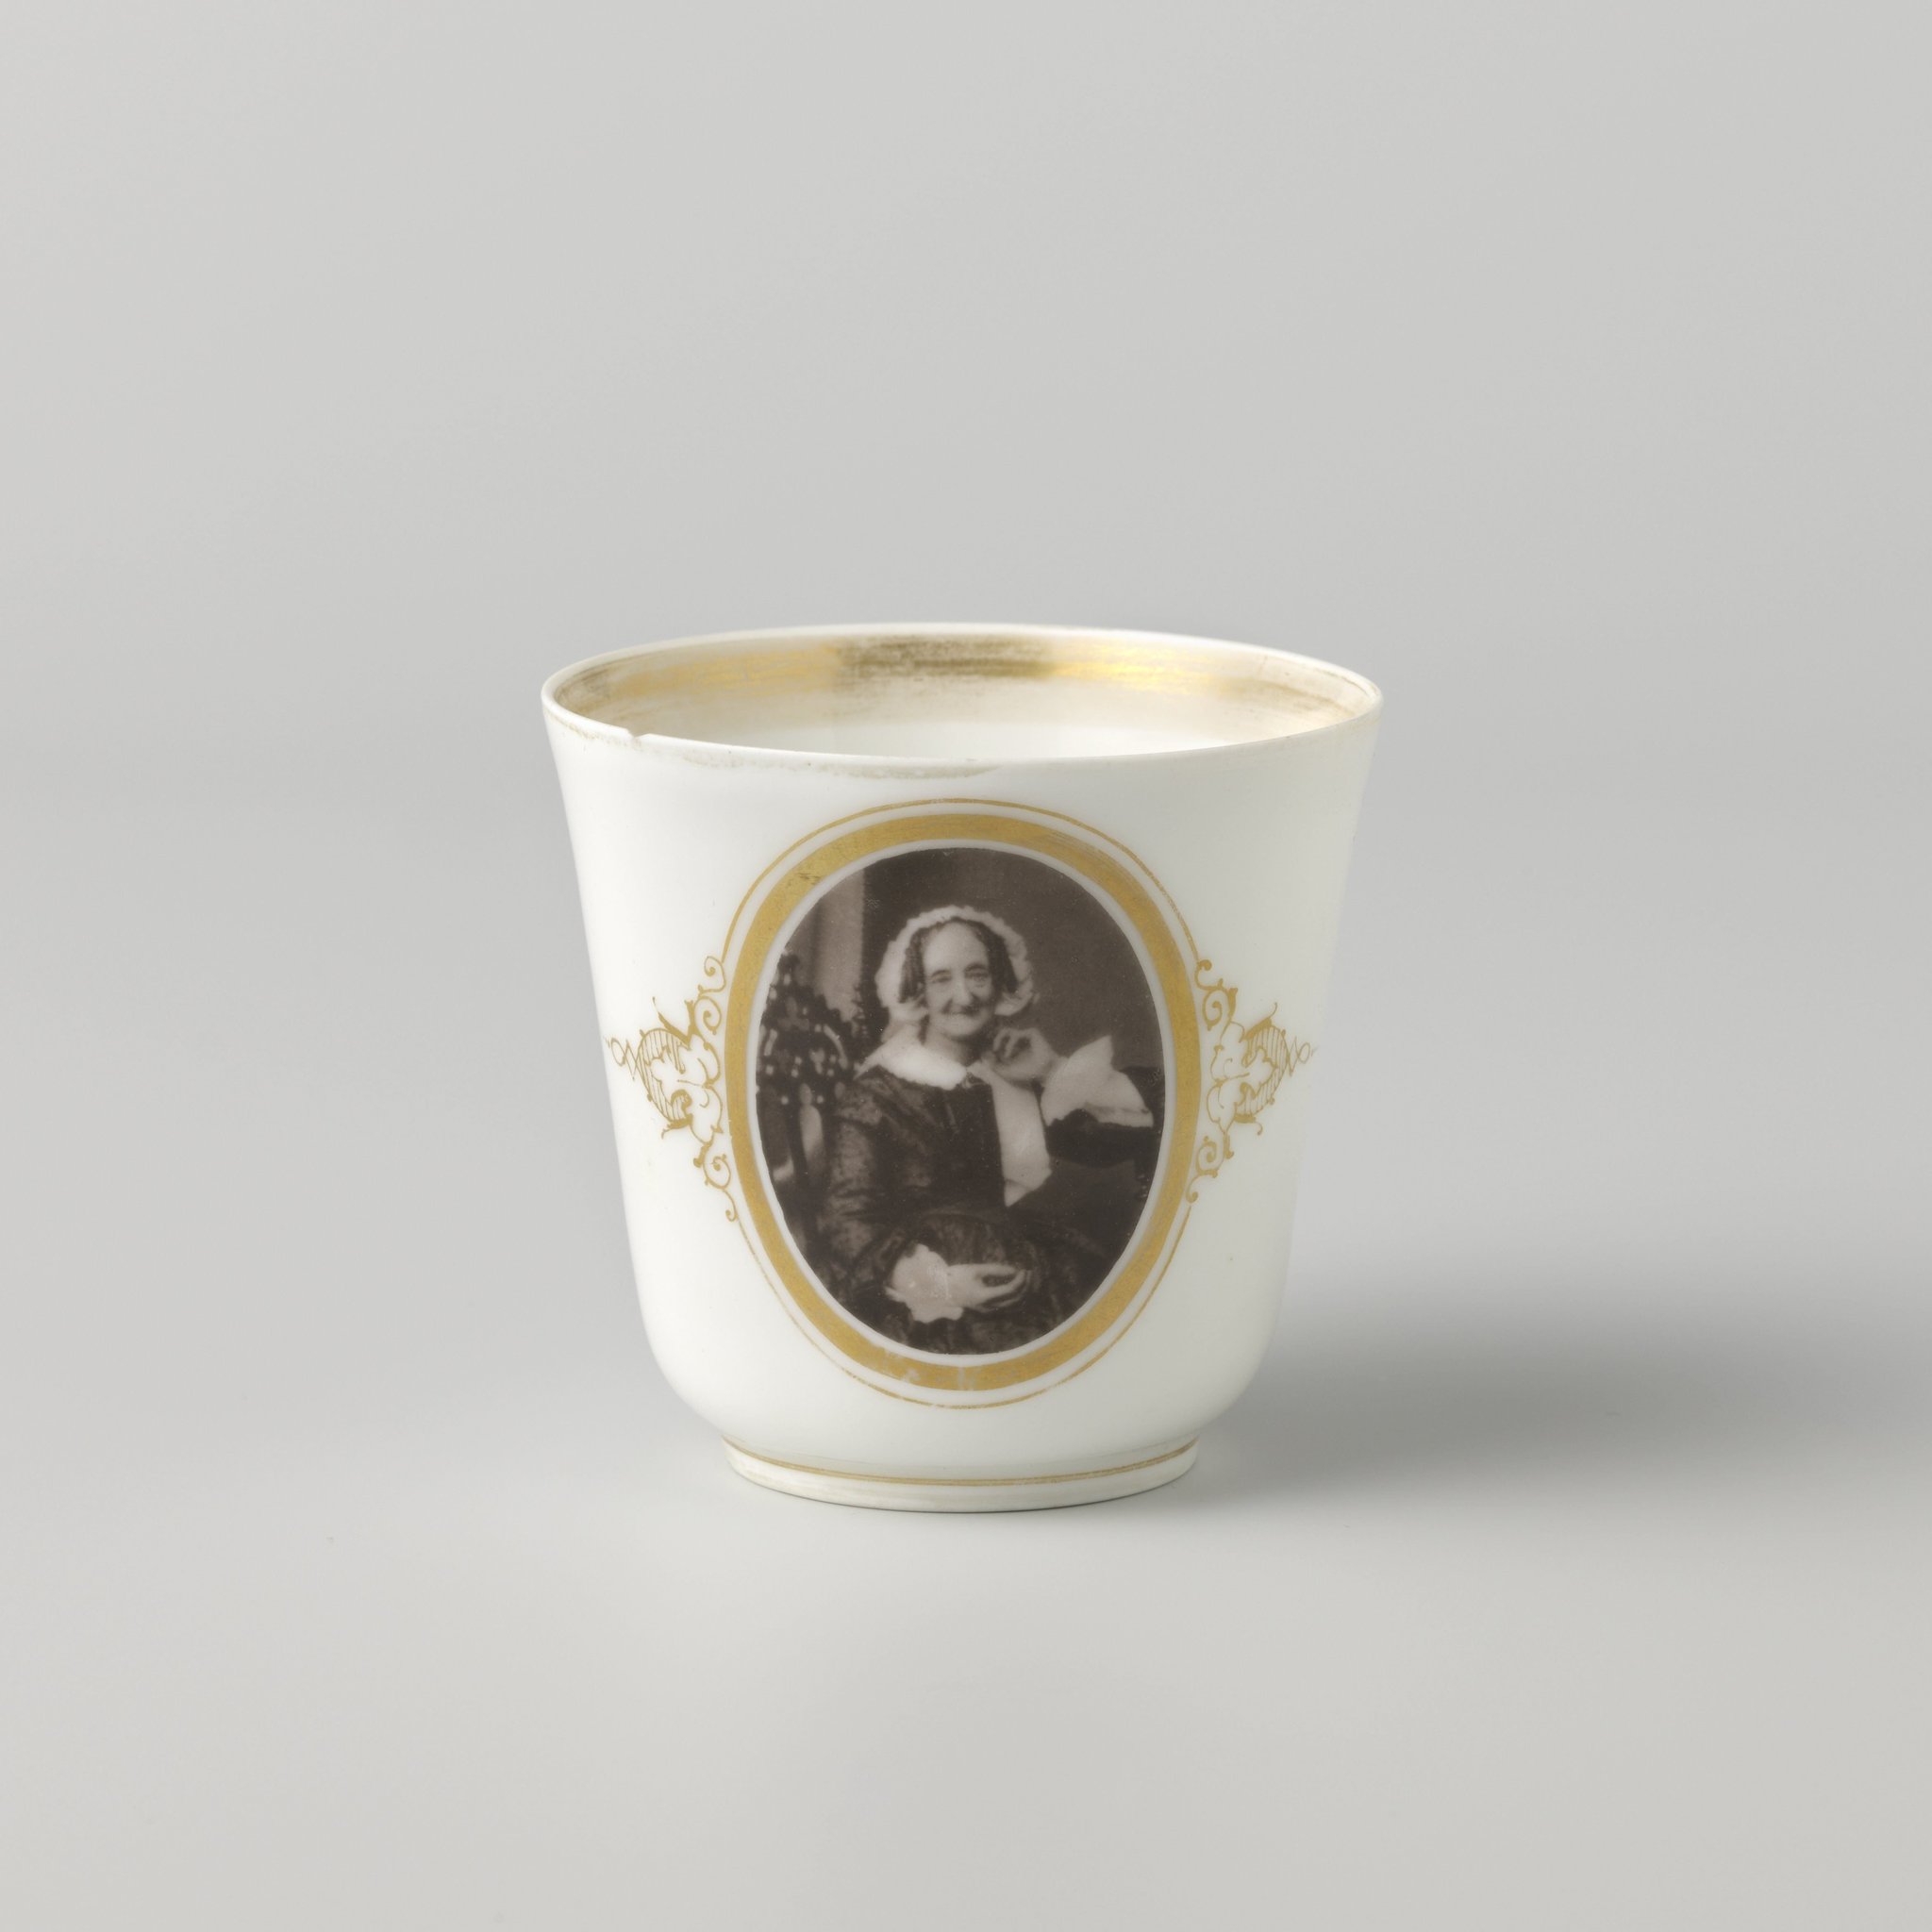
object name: photograph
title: Schotel (zonder afbeelding) met kop met een portret van een dame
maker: Anonymous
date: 1850-1949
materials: ceramic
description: Schotel (zonder afbeelding) met kop met een portret van een dame